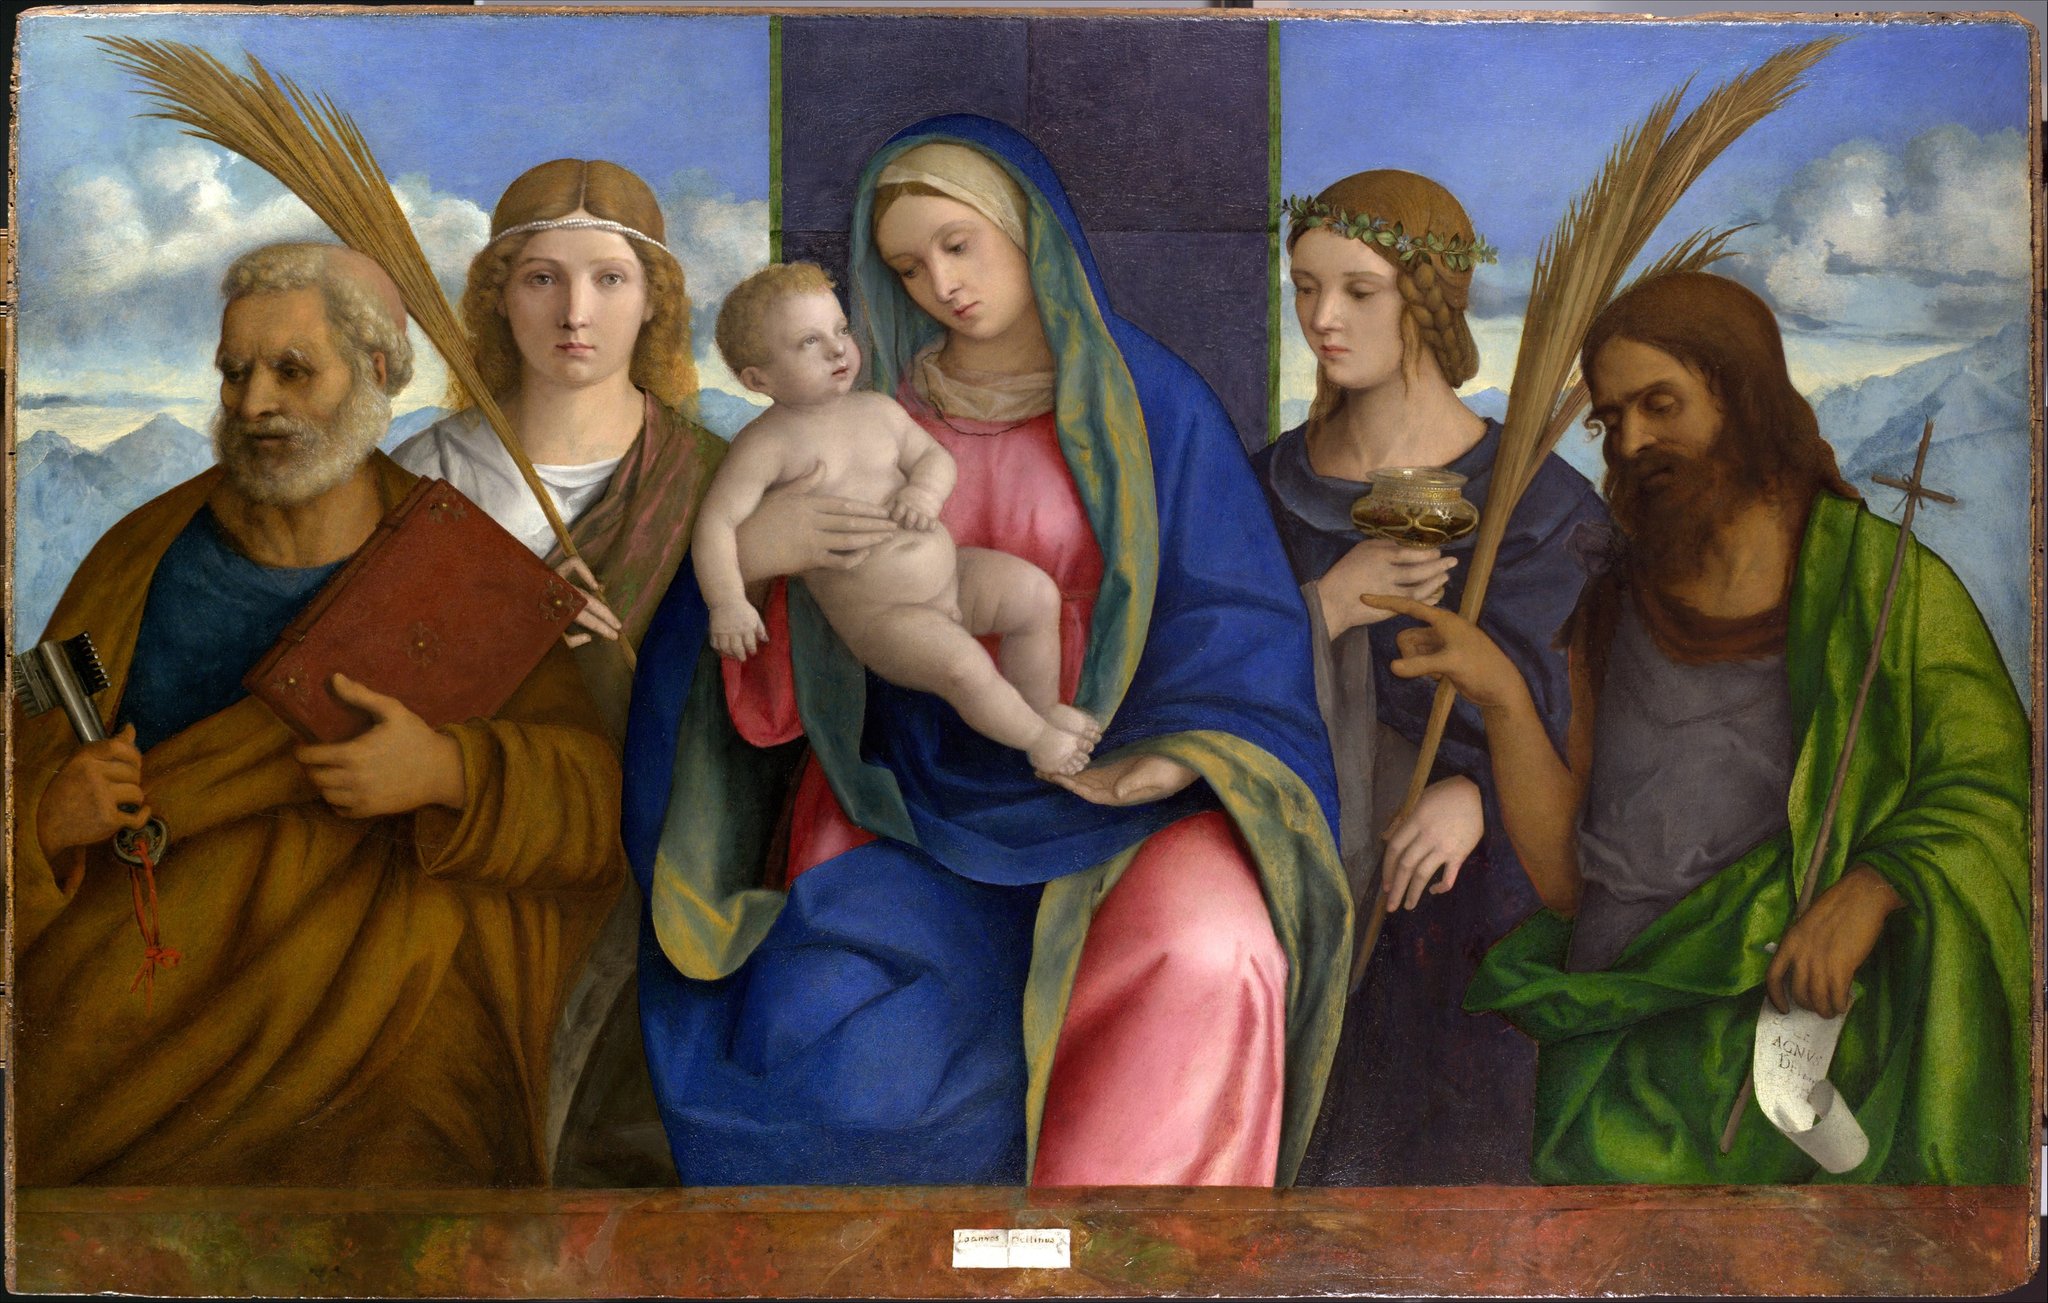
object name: painting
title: Madonna and Child with Saints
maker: giovanni bellini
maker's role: artist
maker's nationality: italian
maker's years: 1424-1516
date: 1505-1510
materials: oil, paint, wood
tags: men,women,madonna and child,saints